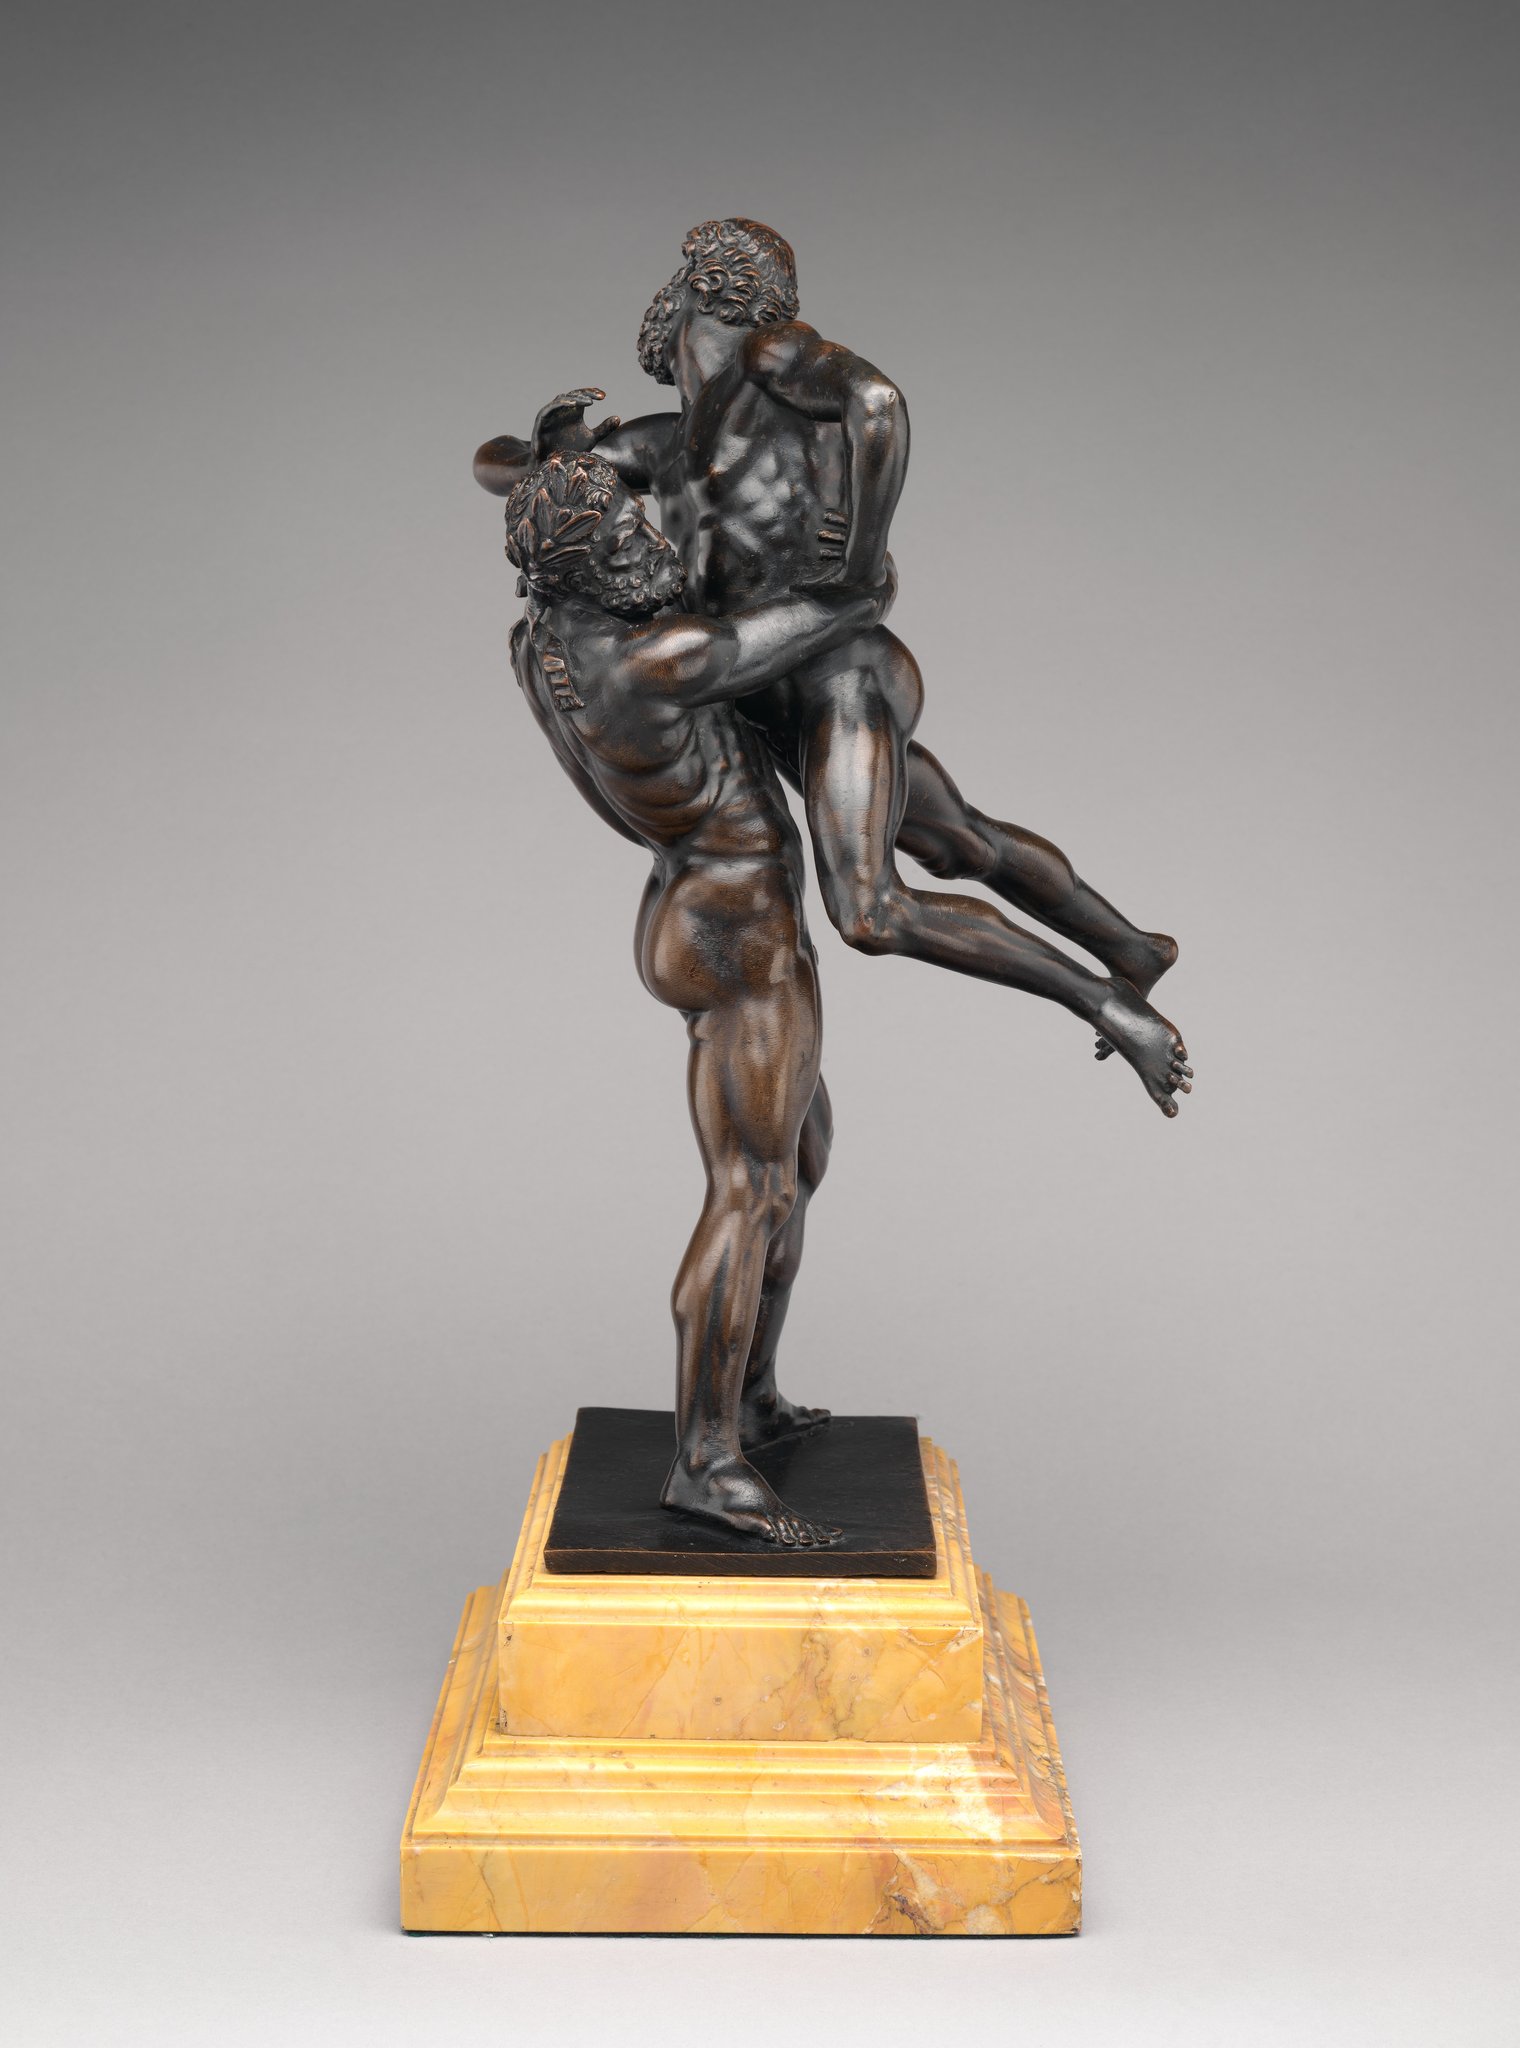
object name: statuette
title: Hercules and Antaeus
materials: bronze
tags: male nudes,hercules